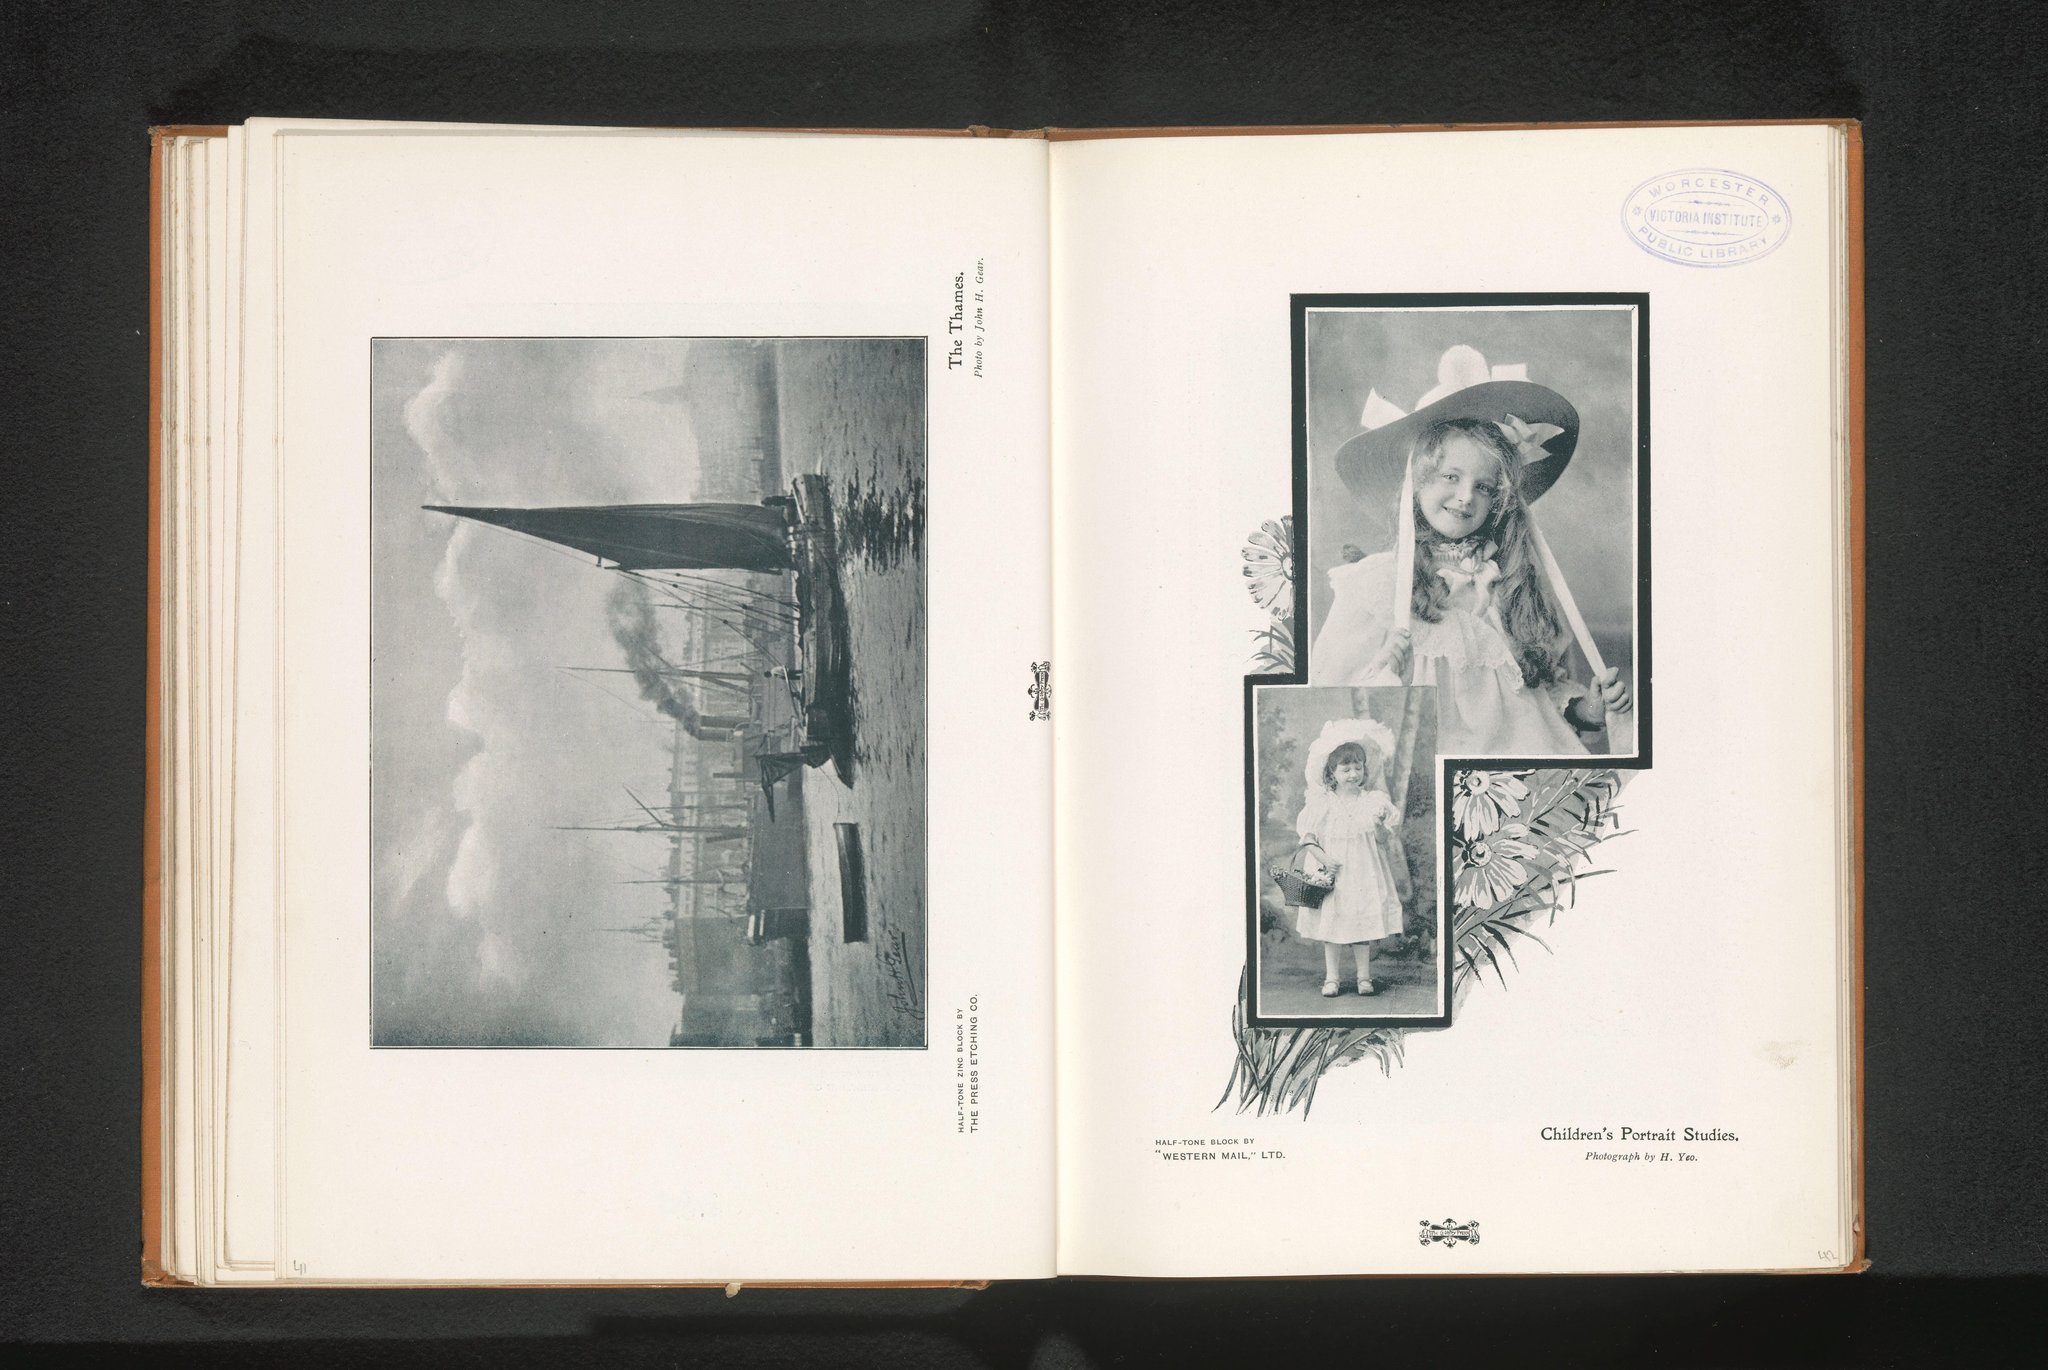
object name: page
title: The Thames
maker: john h. gear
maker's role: fotograaf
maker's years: 1864-1946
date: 1894-1899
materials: paper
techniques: autotype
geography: london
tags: city-view in general; 'veduta', river, sailing-ship, sailing-boat (+ two persons ~ traffic and transport)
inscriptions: collector's mark: ‘Worcester Public Library/ Victoria's Institute’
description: Prent op zesde ongenummerde pagina na pagina 56.